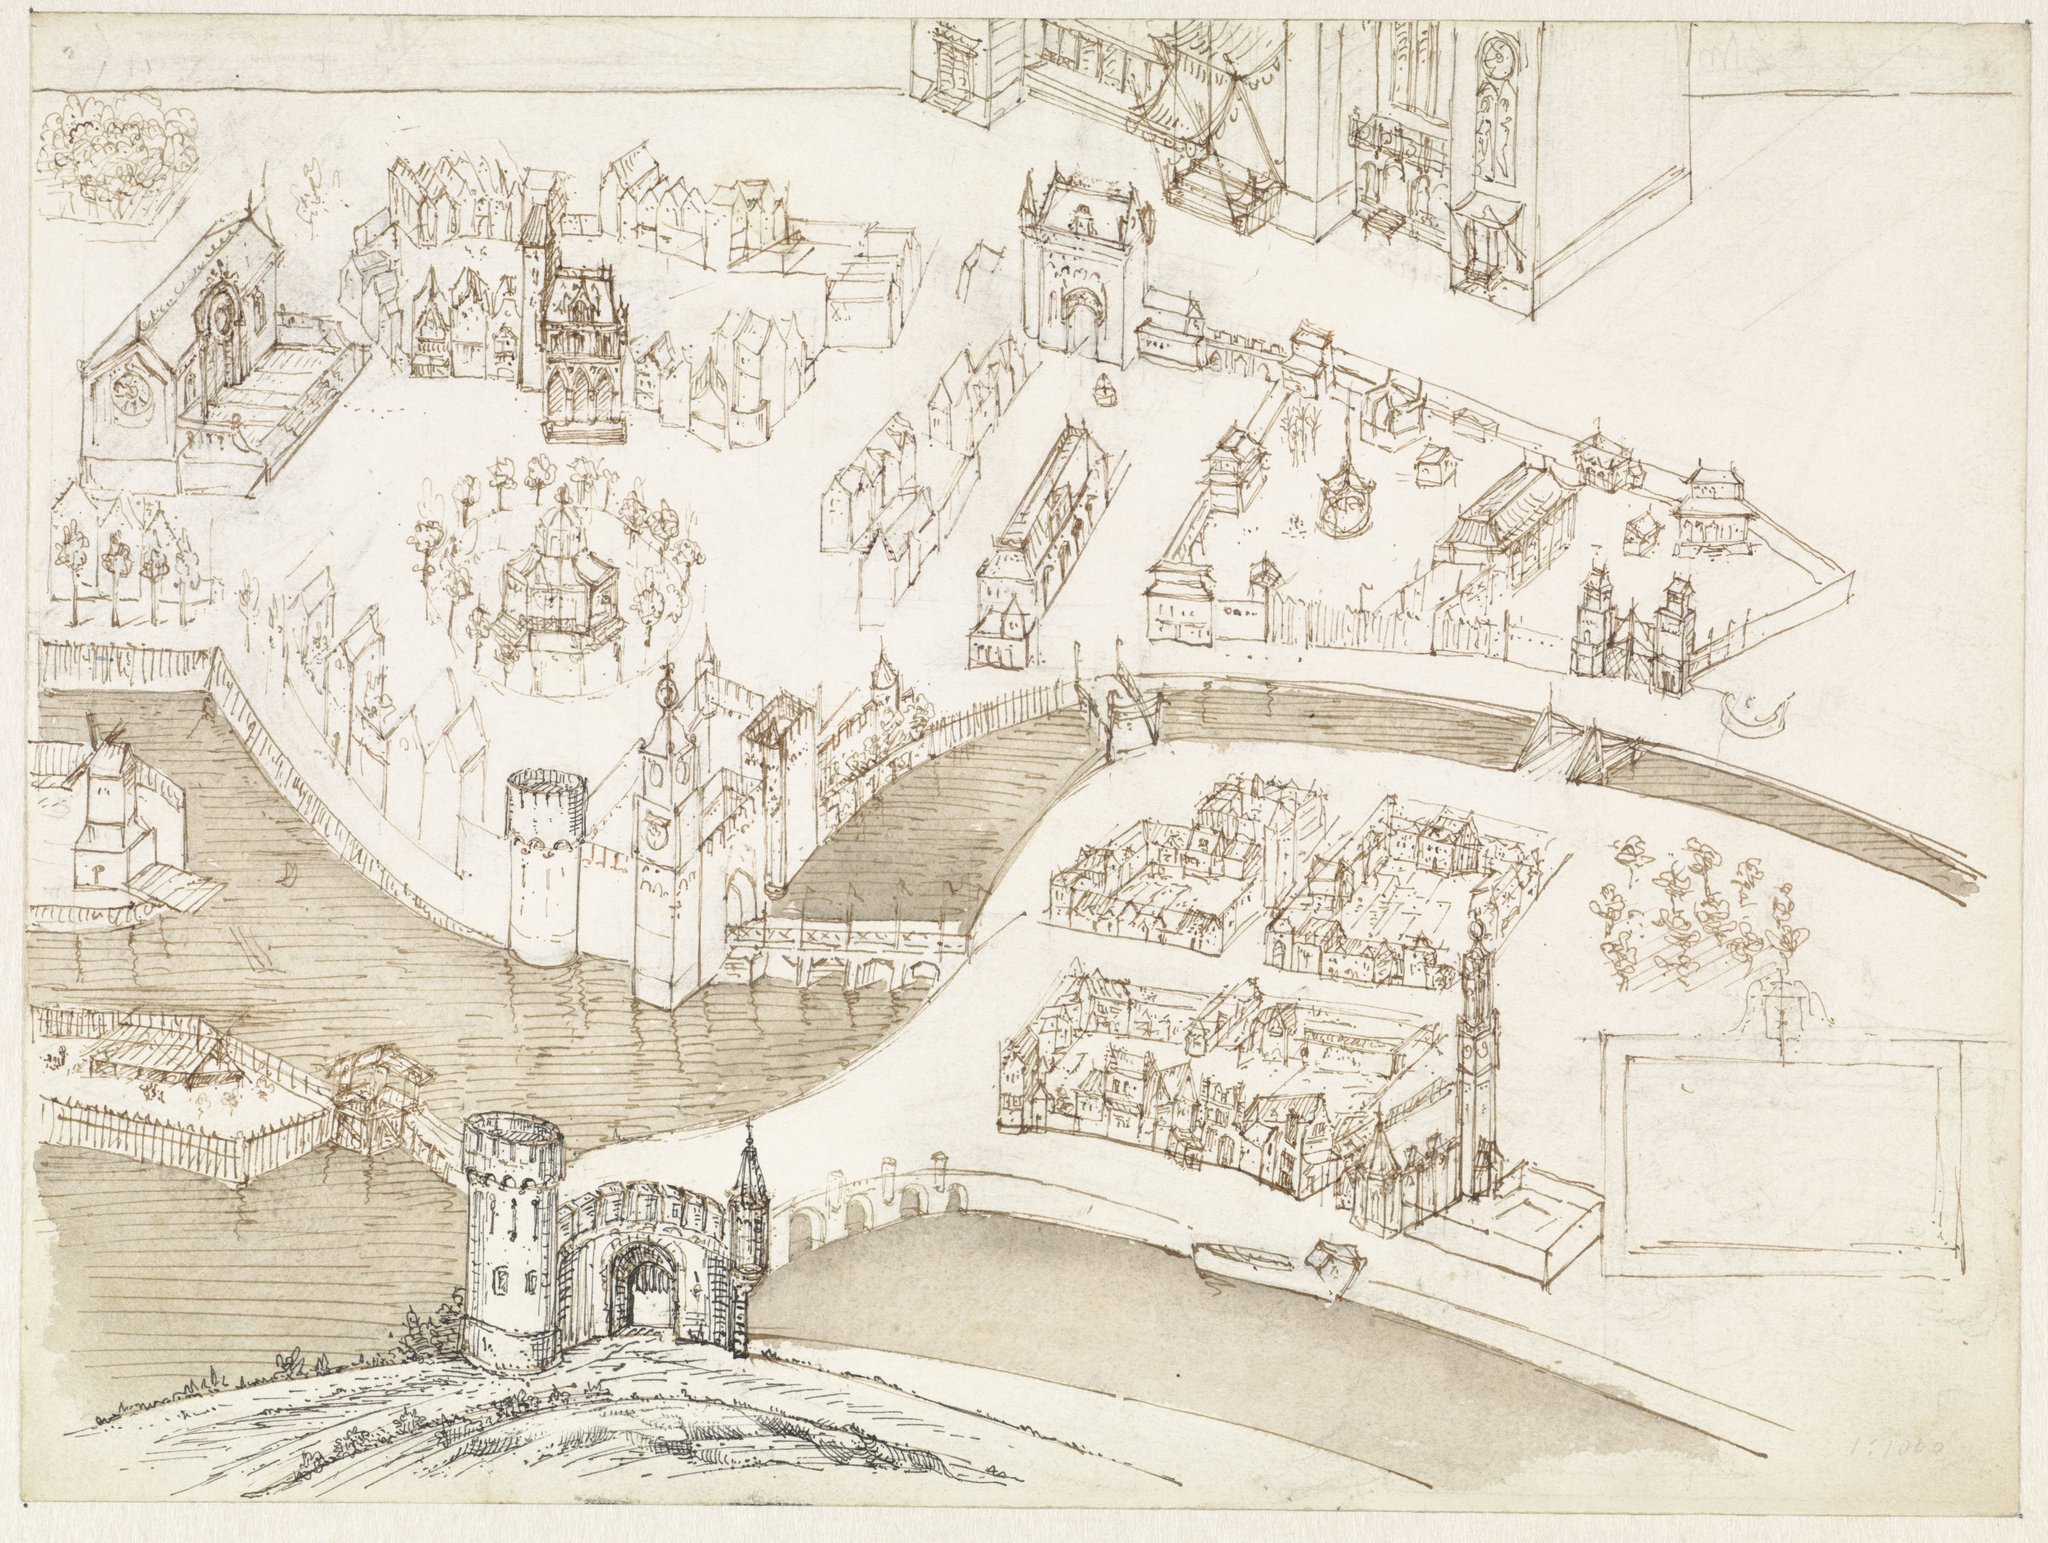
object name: drawing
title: Ontwerp voor een maquette van een middeleeuwse stad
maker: jacob gosschalk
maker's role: draughtsman, print maker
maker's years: 1840-1893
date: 1850-1893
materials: ink, paper, pencil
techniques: brush, pen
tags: prospect of city, town panorama, silhouette of city